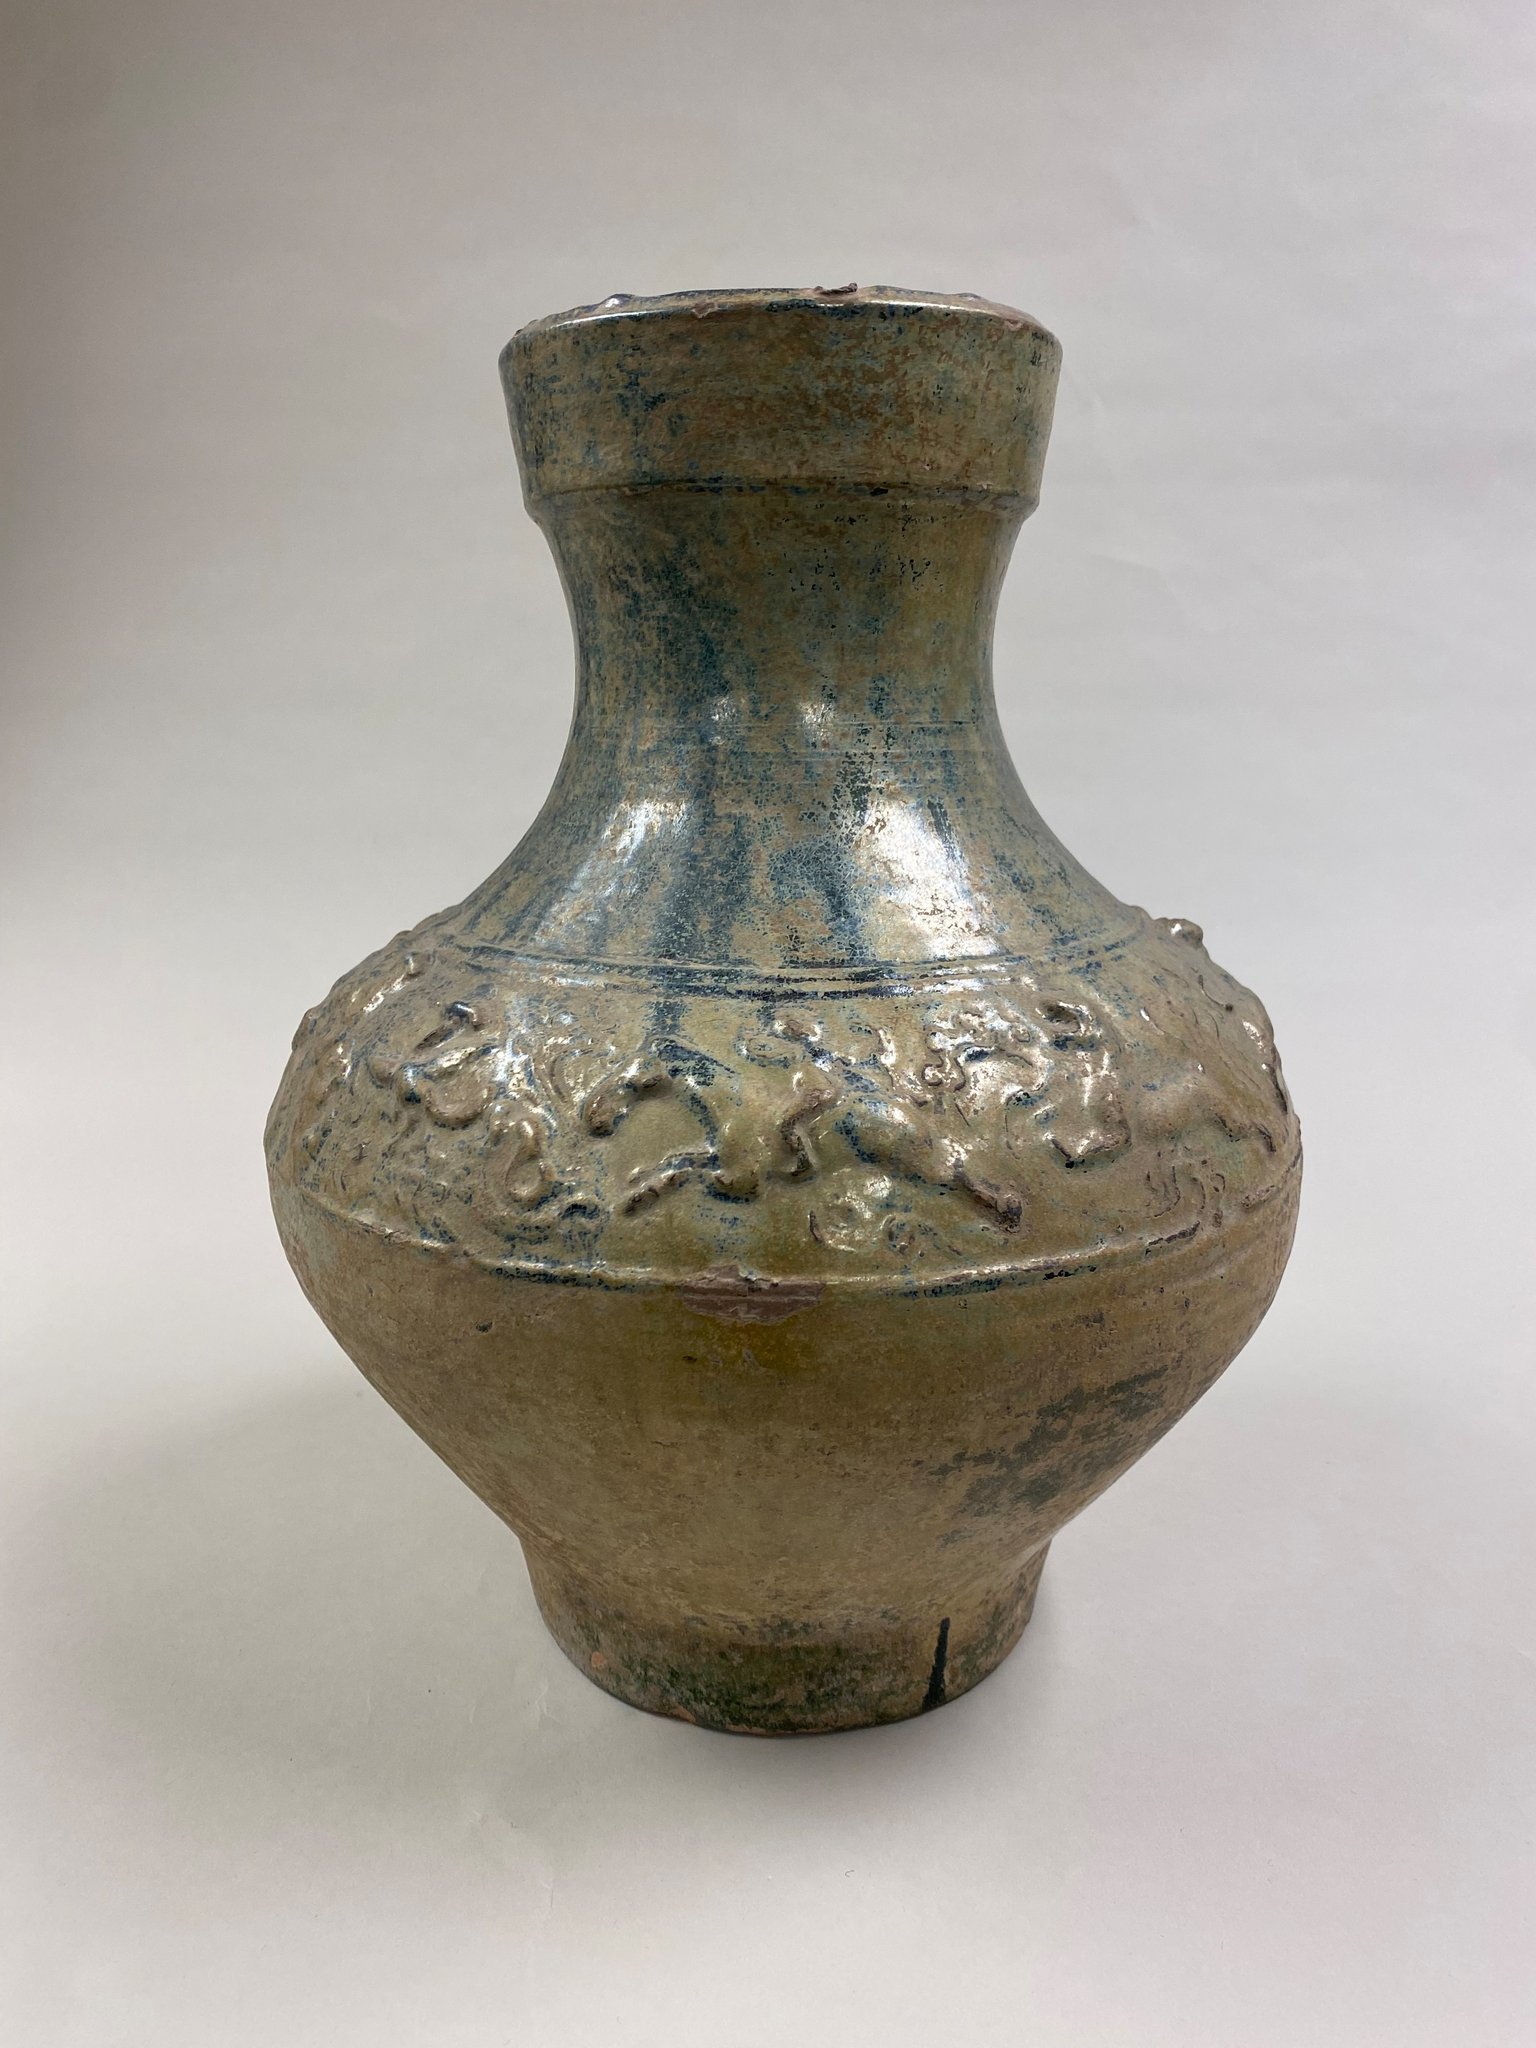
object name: wine container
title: Wine container (hu) with mythical creatures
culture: chinese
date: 1-200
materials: earthenware, glaze, lead